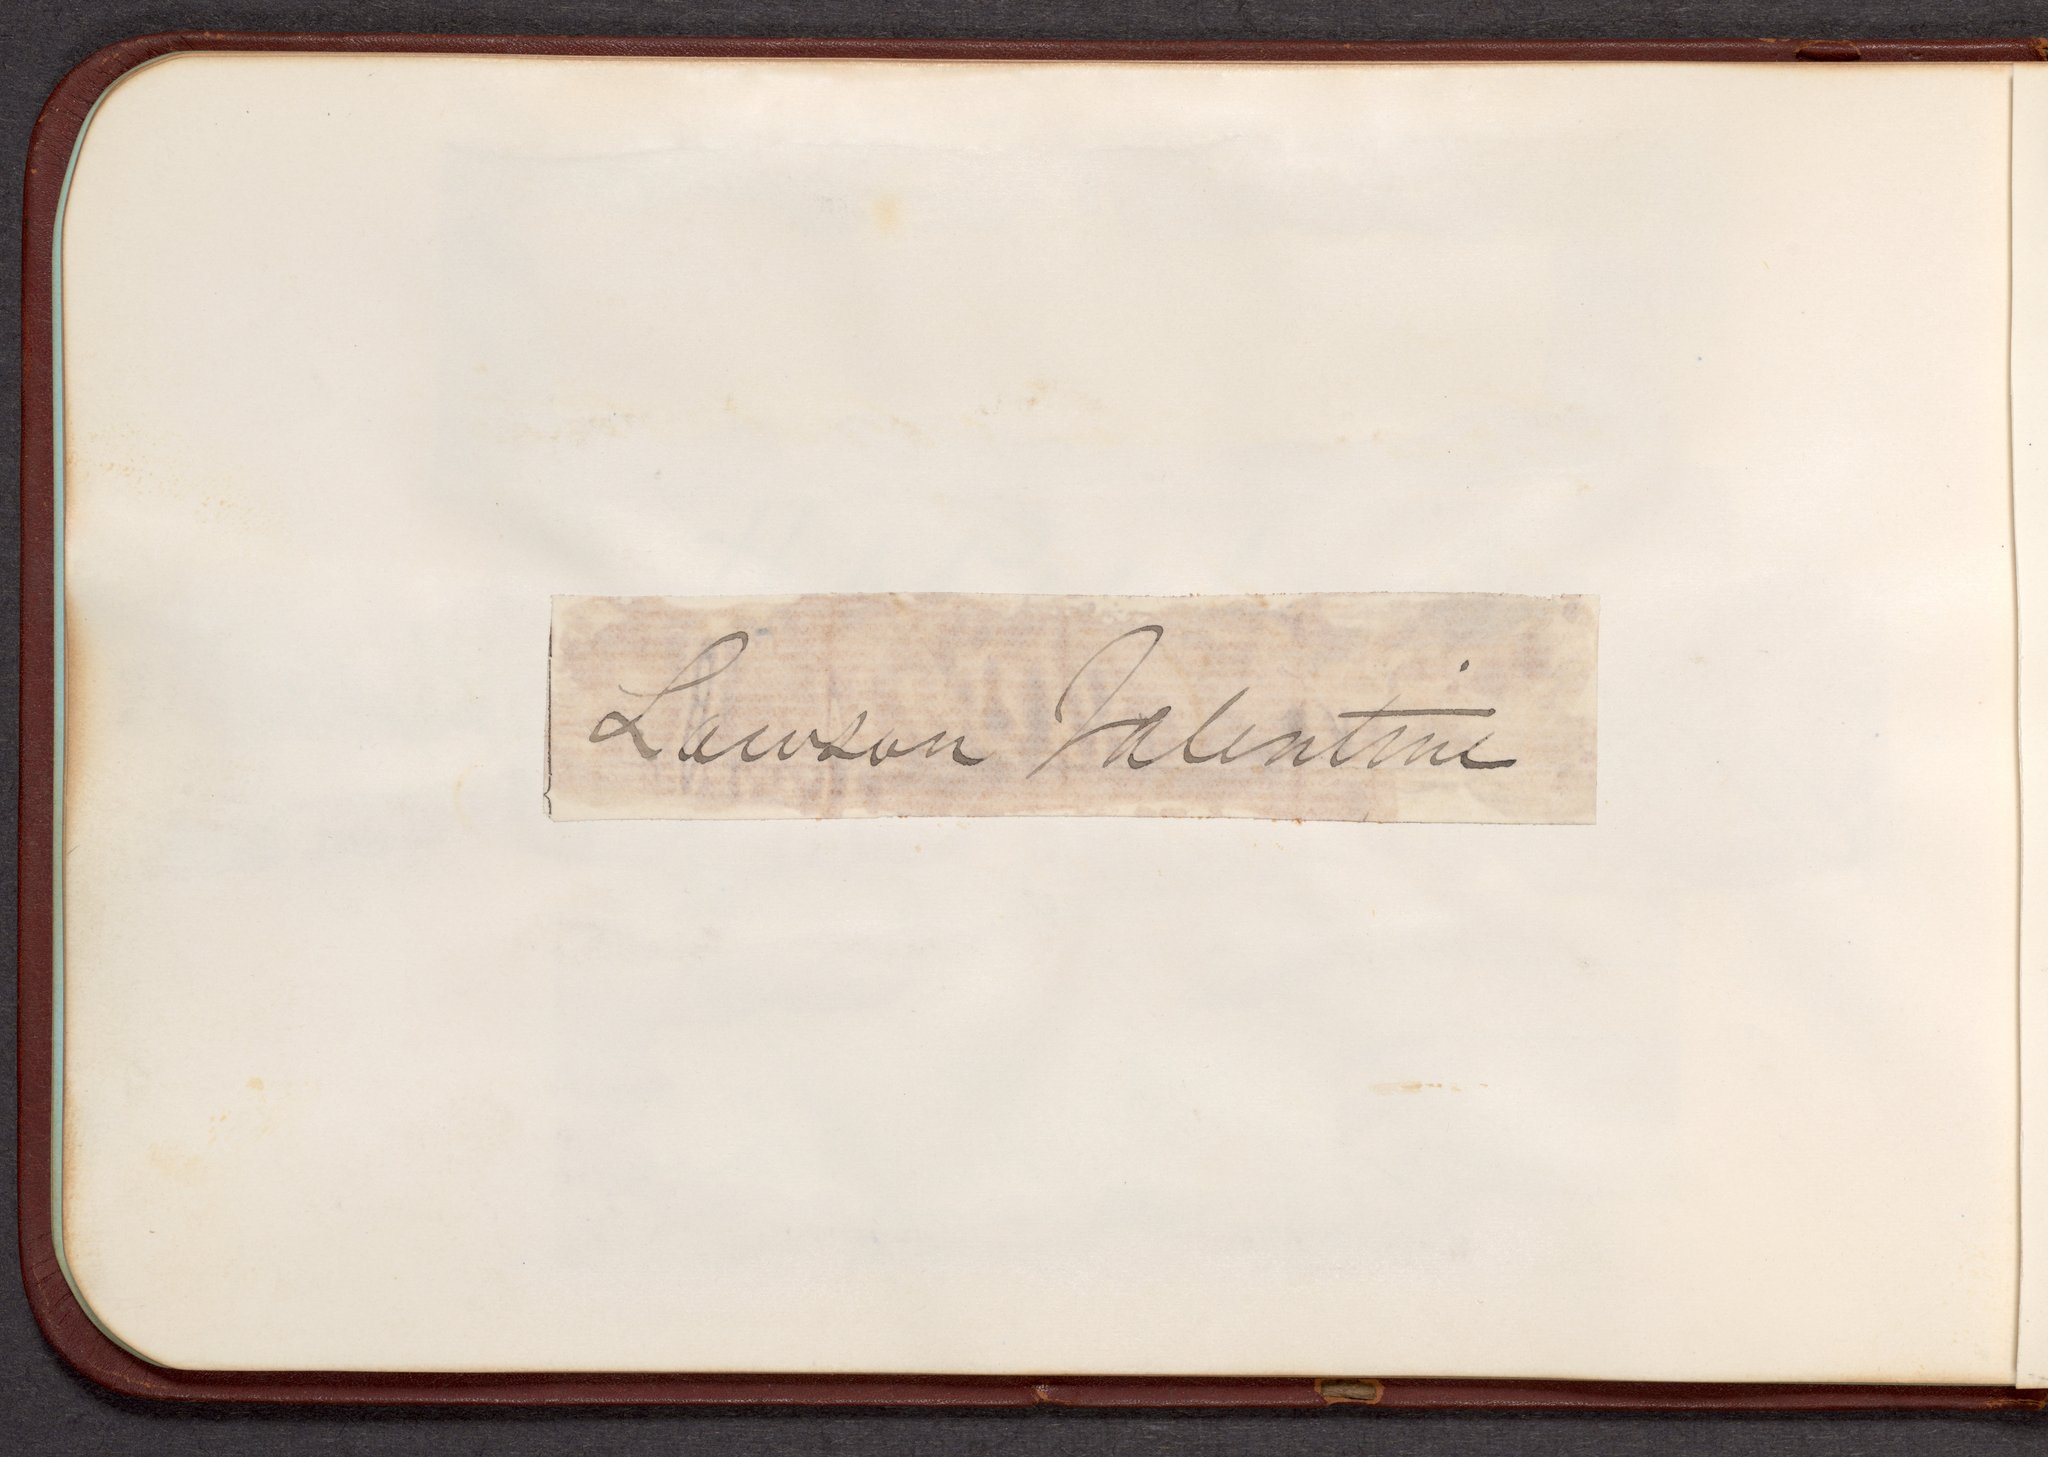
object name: book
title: Carriage makers' autograph book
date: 1878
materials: gold, ink, leather, paper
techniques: treatment